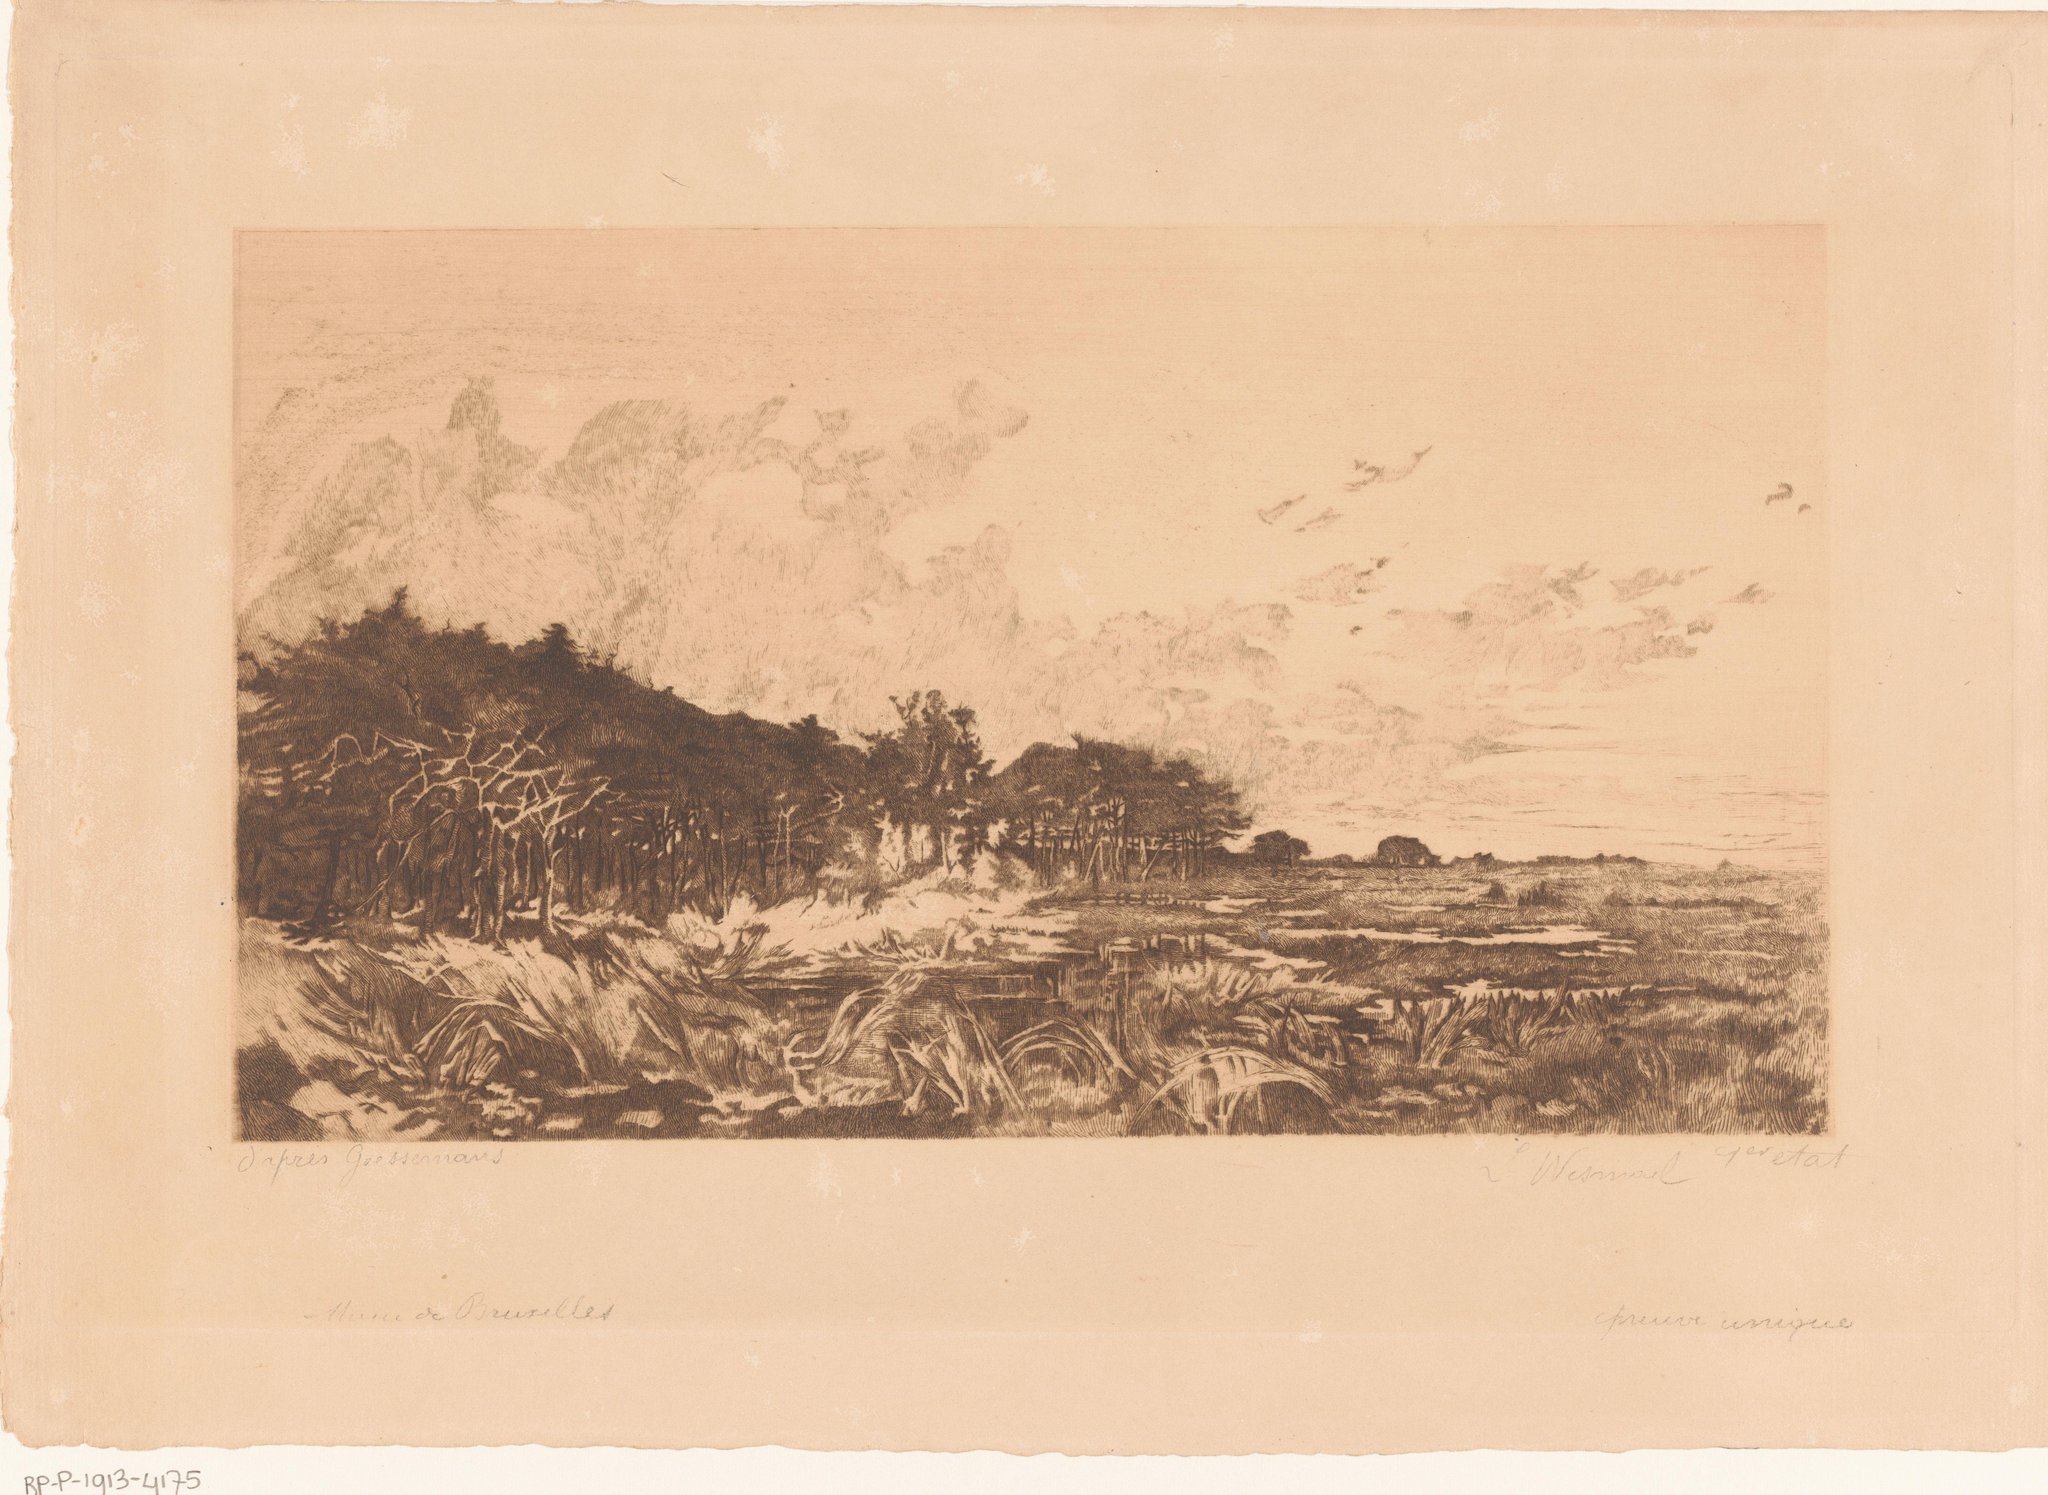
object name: print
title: Landschap met bomen langs een moeras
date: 1883-1913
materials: paper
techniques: drypoint, etching, intaglio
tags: swamp, inland marsh, fens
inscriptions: collector's mark: Lugt 2228, watermark